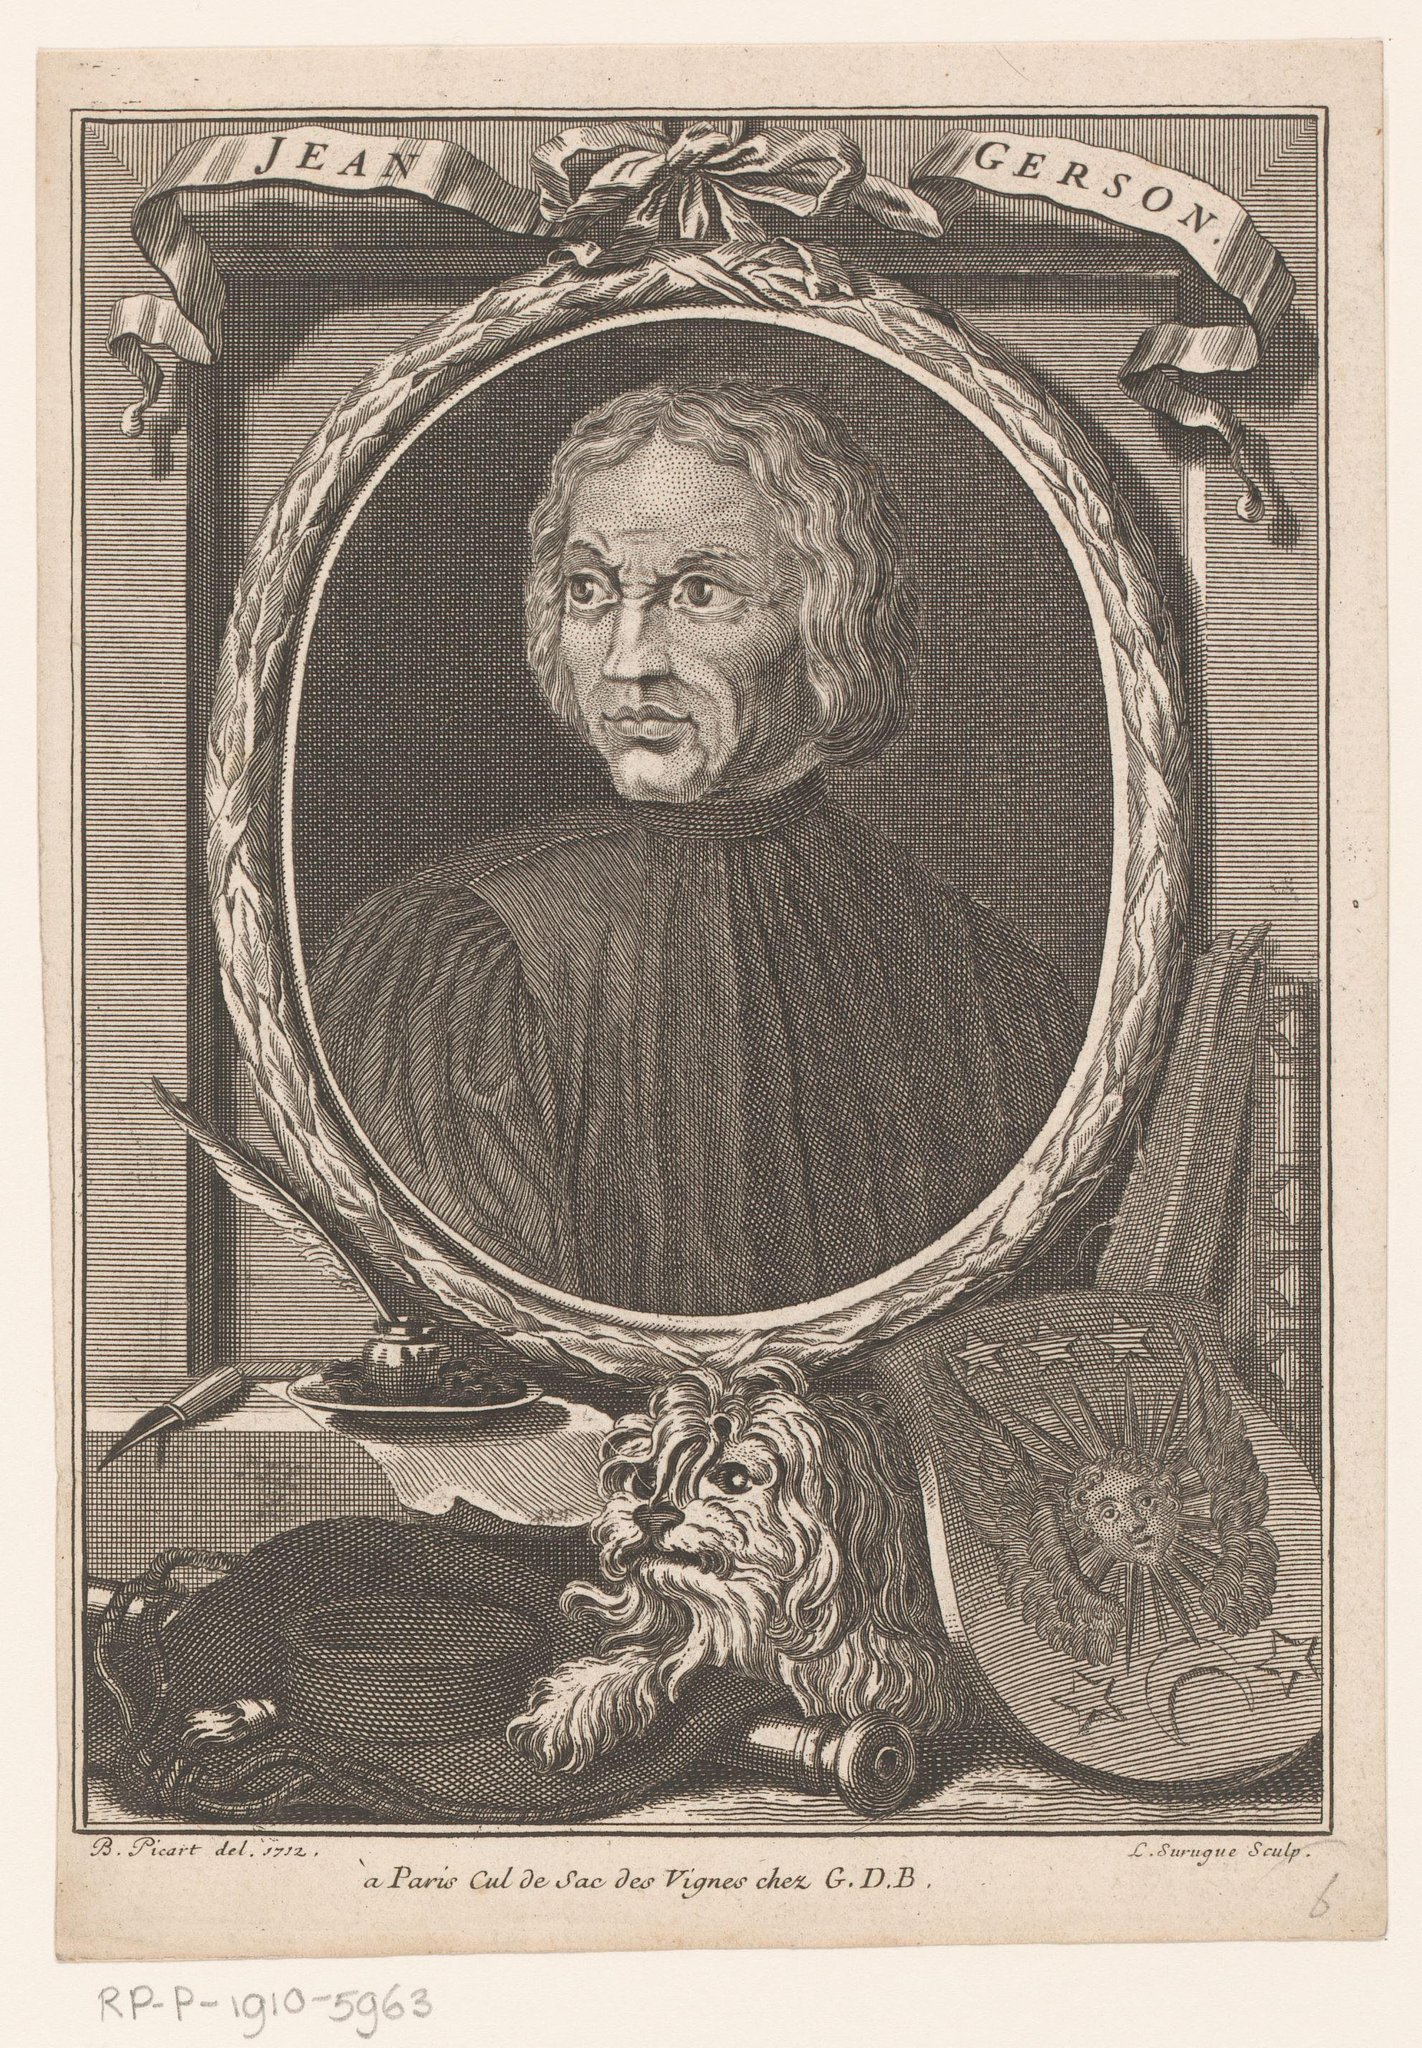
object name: print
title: Portret van Jean de Gerson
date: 1712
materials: paper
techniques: engraving, etching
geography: paris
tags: theologian, historical persons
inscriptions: collector's mark: Lugt 2228